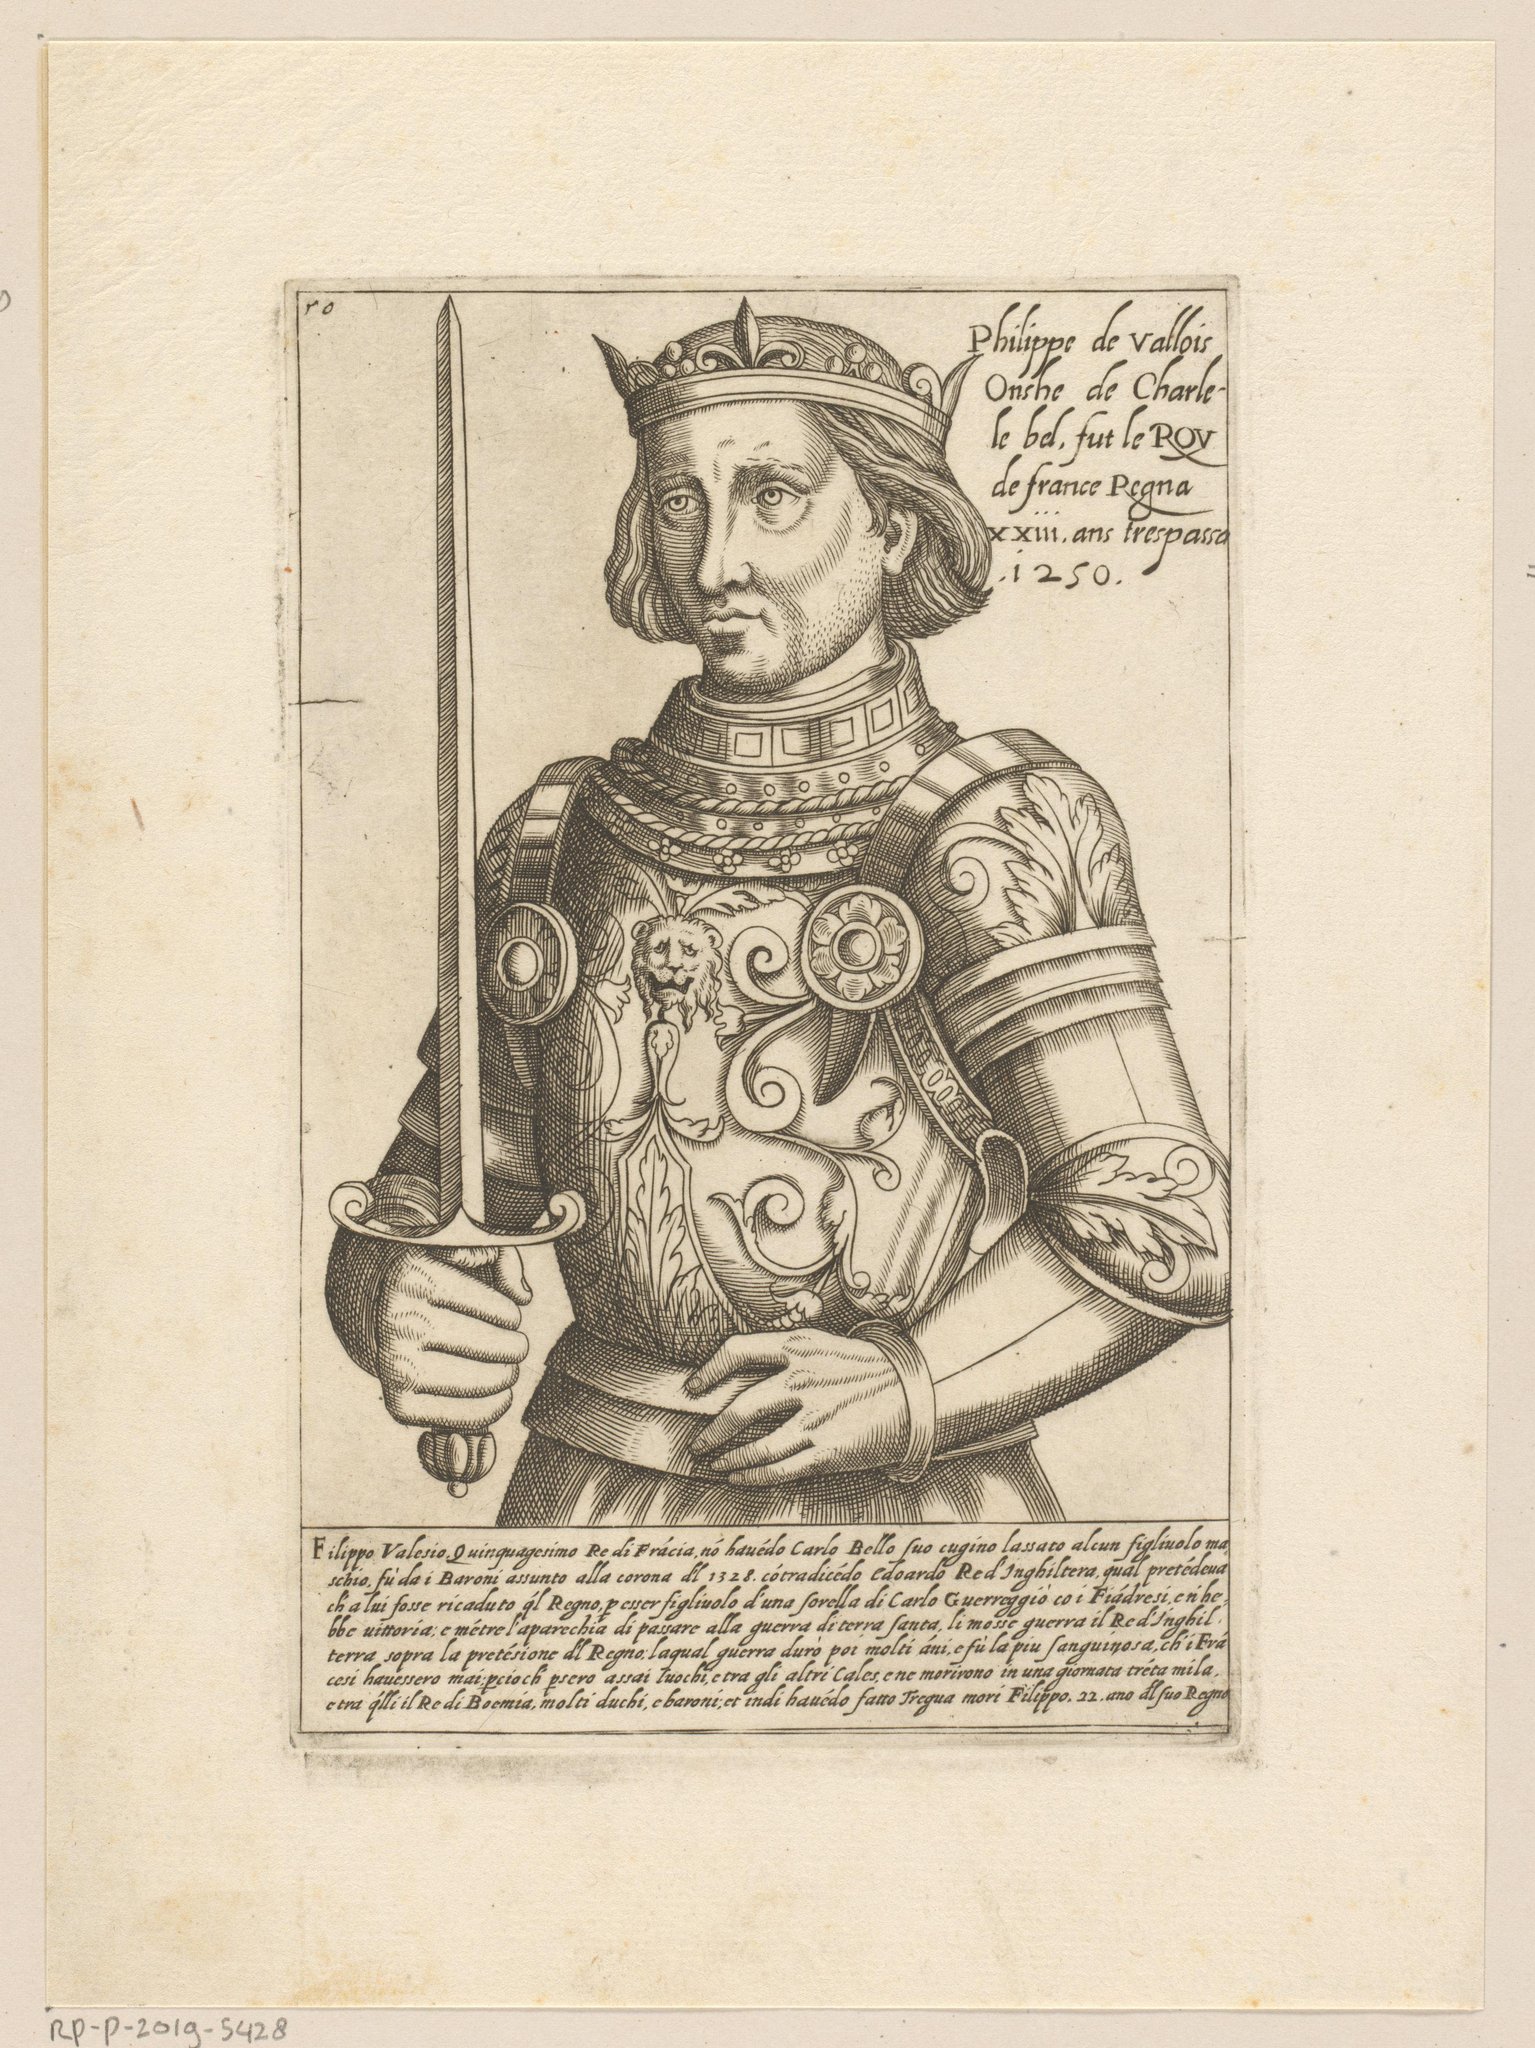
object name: book illustration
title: Portret van Filips VI, koning van Frankrijk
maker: Anonymous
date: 1588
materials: paper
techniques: engraving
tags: crown (symbol of sovereignty), historical persons, hacking and thrusting weapons: sword, king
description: Prent voor het eerst gebruikt in: Cronica Breve de i fatti illustri de're di Francia, con le loro effigie dal naturale cominciando da Faramondo (...). Venetië: Bernardo Giunti, 1588. Prent in ieder geval ook gebruikt in de editie van 1590 en mogelijk ook in een Franse uitgave van 1597.